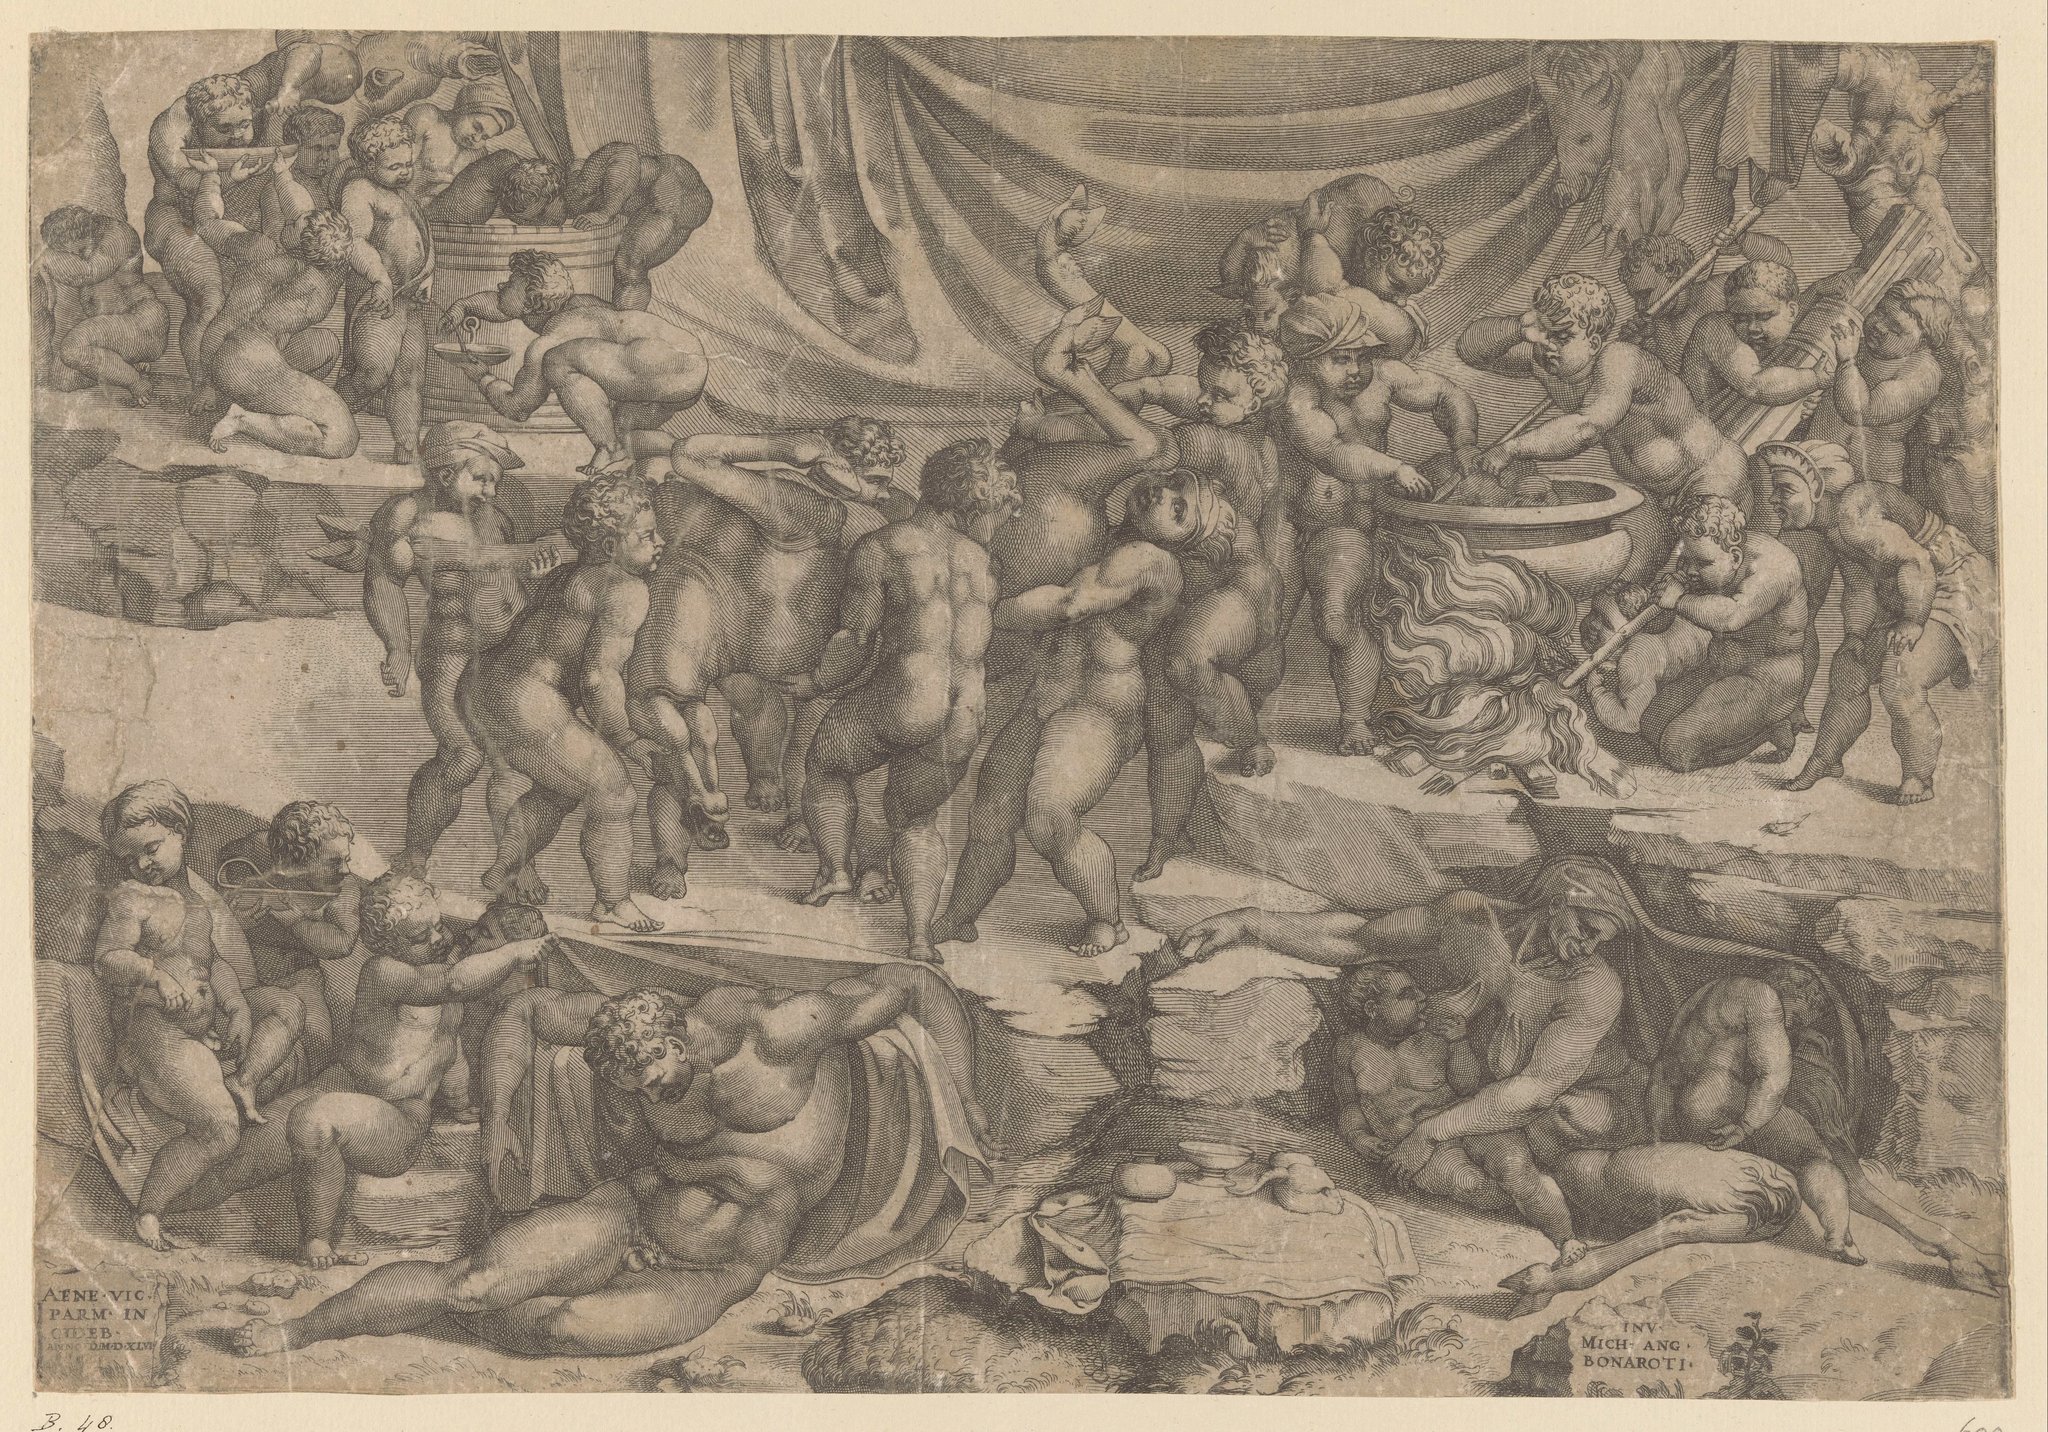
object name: print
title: Bacchanaal met putti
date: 1546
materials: paper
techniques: engraving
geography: italy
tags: children's bacchanal, cupids: 'amores', 'amoretti', 'putti'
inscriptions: collector's mark: Lugt 240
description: Een bacchanaal met putti. In het midden putti die een ezel dragen. Rechtsonder een sater die een putto zoogt. Linksonder een naakte man.